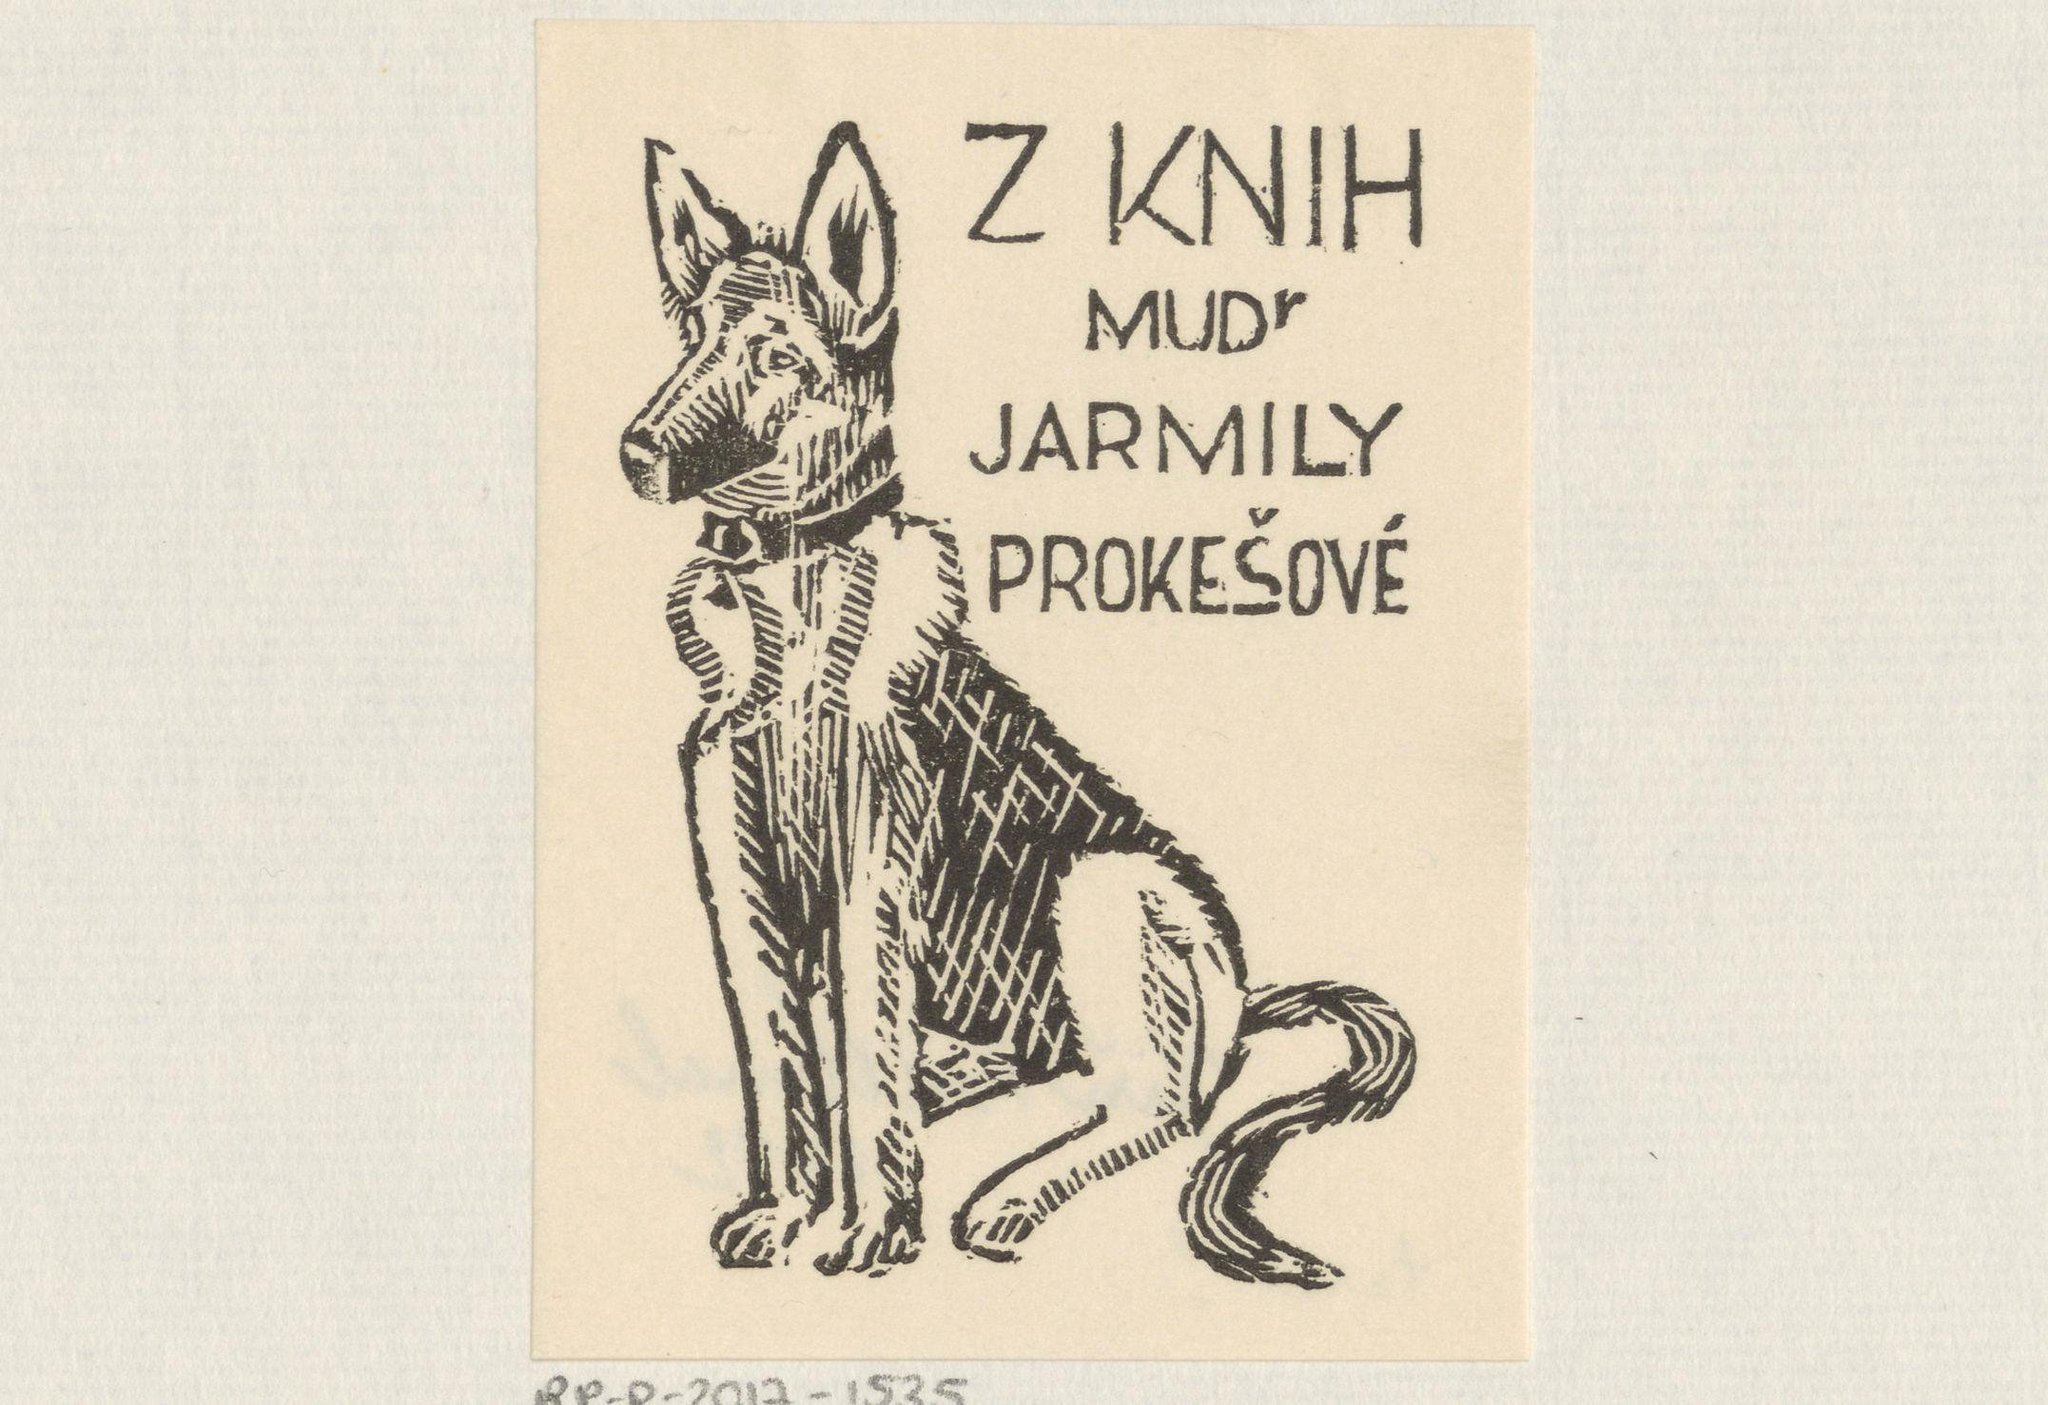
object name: bookplate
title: Ex libris van Jarmily Prokešové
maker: jiří vodehnal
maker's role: print maker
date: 1942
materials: paper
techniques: woodcut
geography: czechoslovakia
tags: dog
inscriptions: inscription: ‘Jiří Vodehnal / 1942’